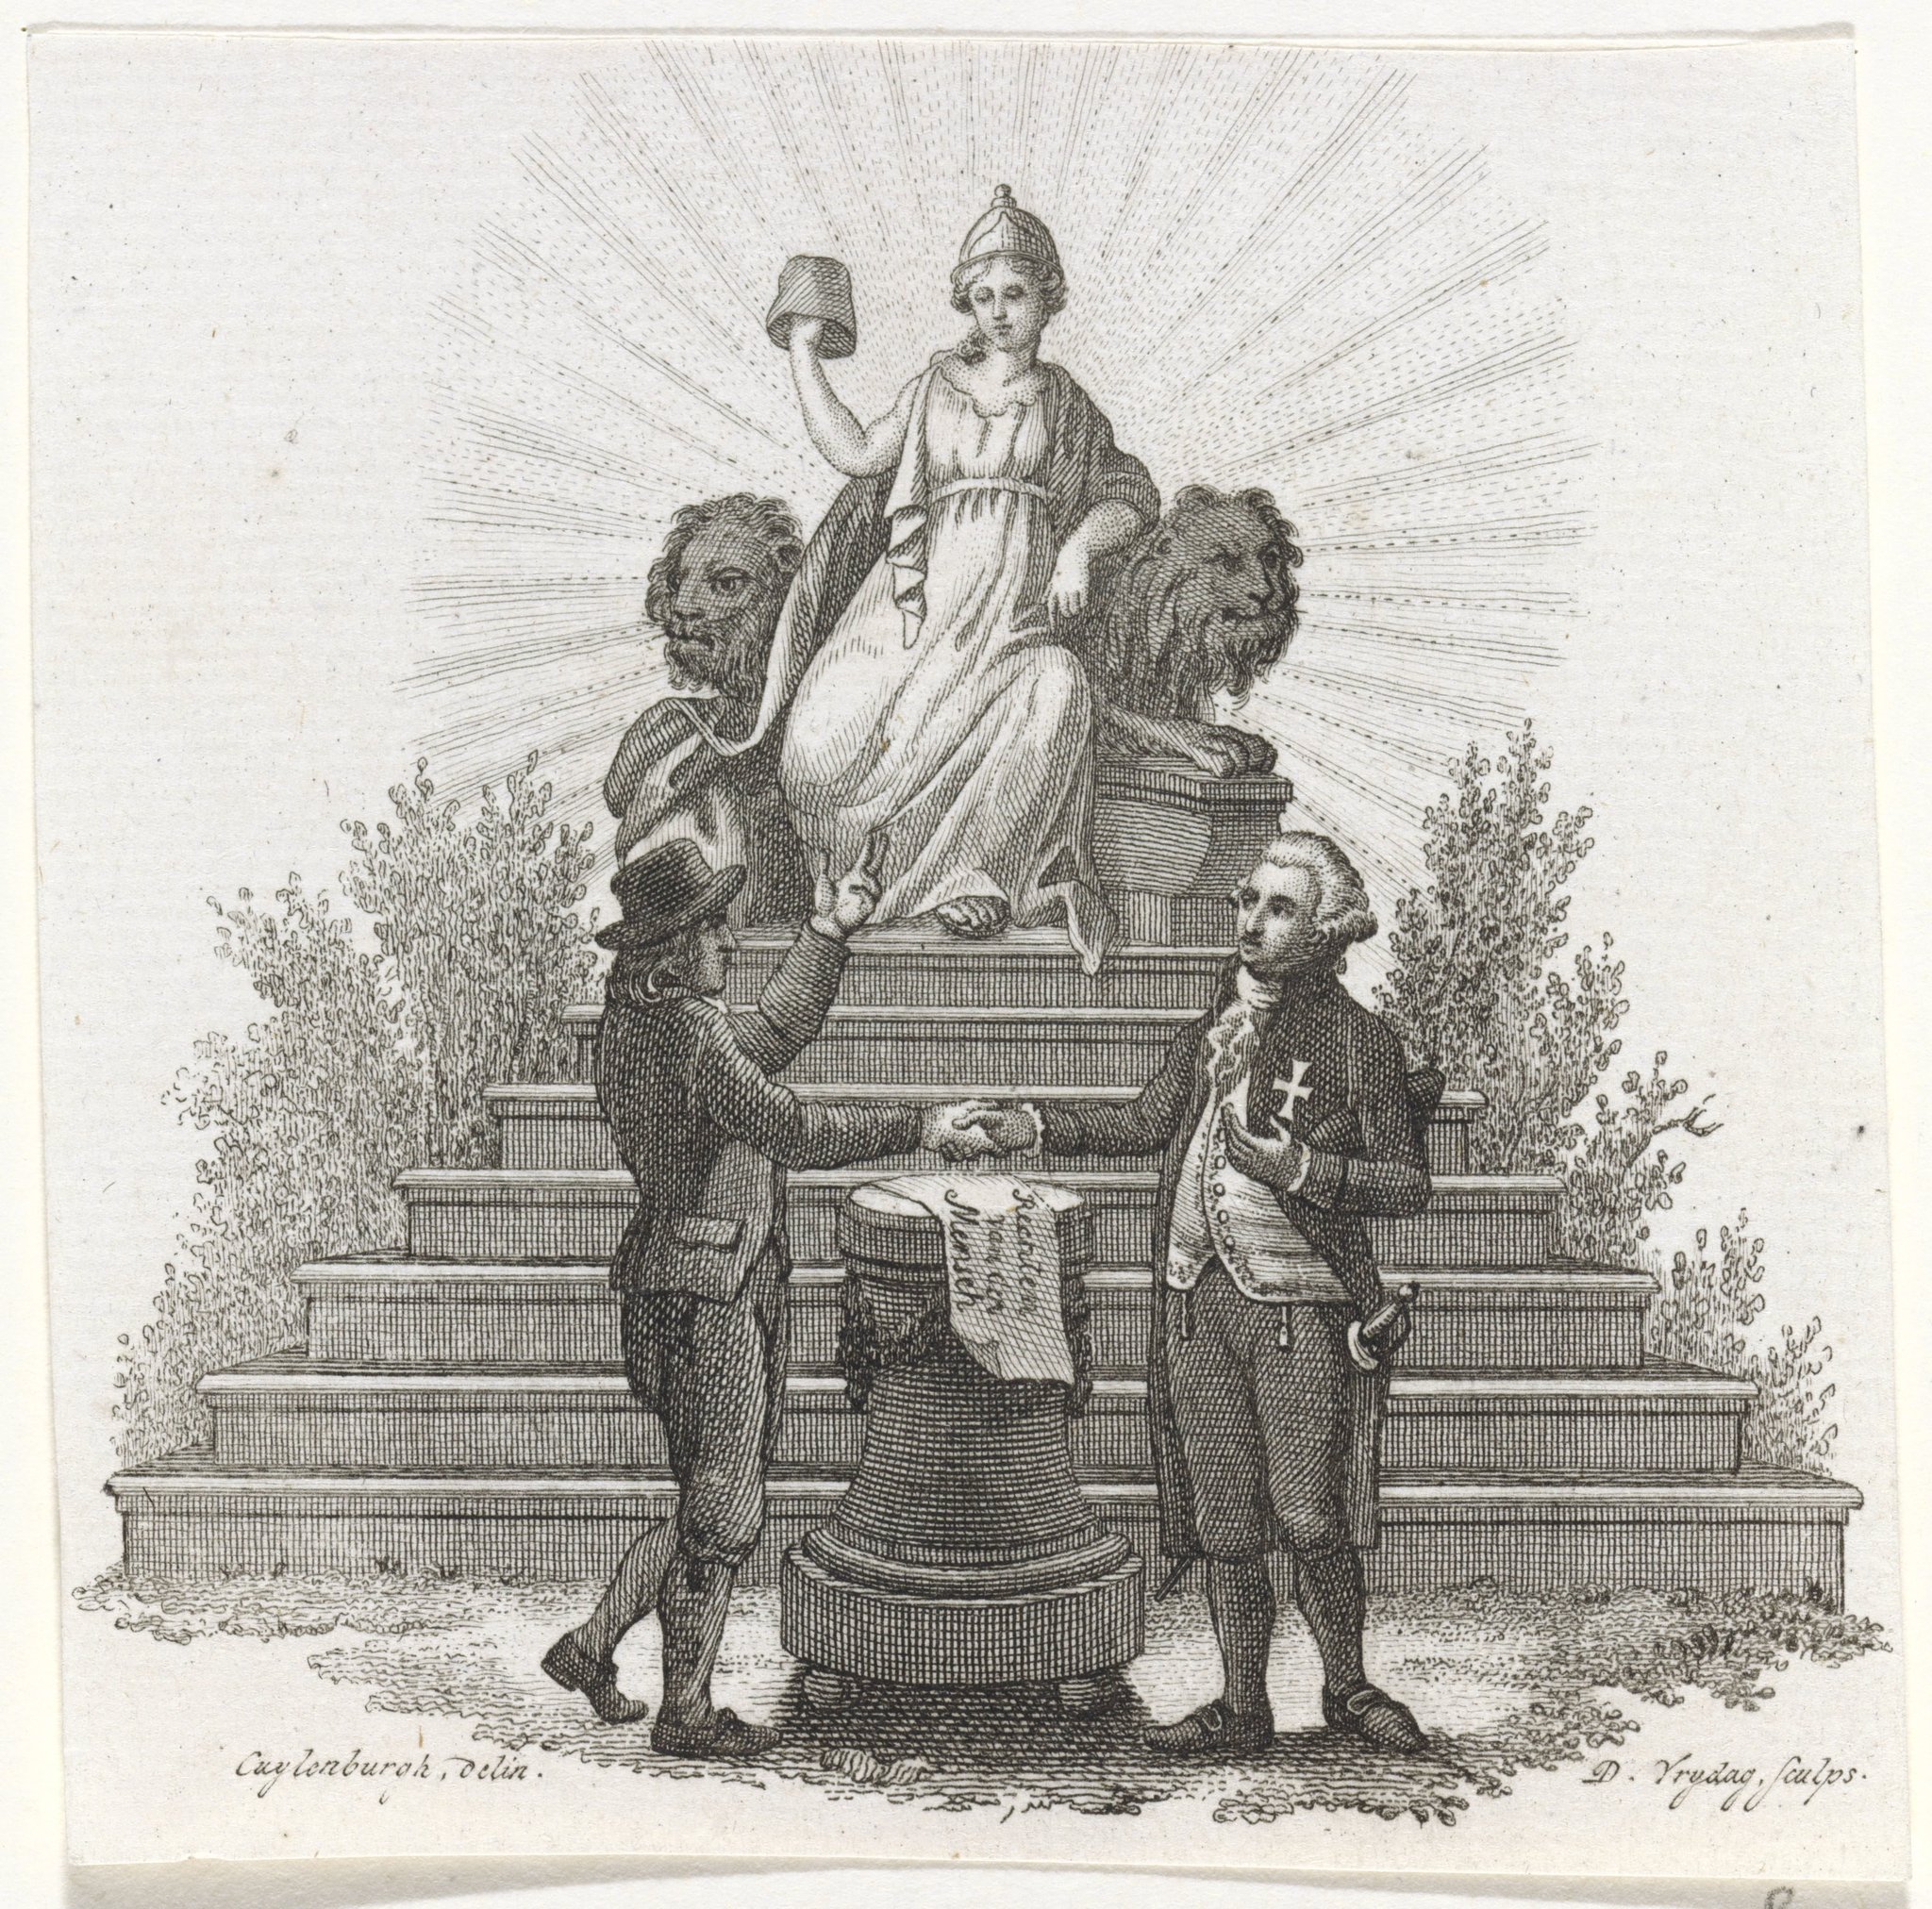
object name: print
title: Titelvignet, 1799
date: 1799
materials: paper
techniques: engraving, etching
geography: netherlands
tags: revolutionaries taking the oath, swearing an oath (with two fingers raised), freedom, liberty; 'libertà' (ripa) (+ abstract concept represented by female figure)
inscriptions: collector's mark: Lugt 2228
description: Patriots titelvignet op een titelpagina van 1799 waarin een burger en een edelman elkaar de hand schudden en de burger een eed aflegt op het altaar van de Rechten van de Mens. Op de achtergrond troont de Vrijheid of de Republiek tussen twee leeuwen.